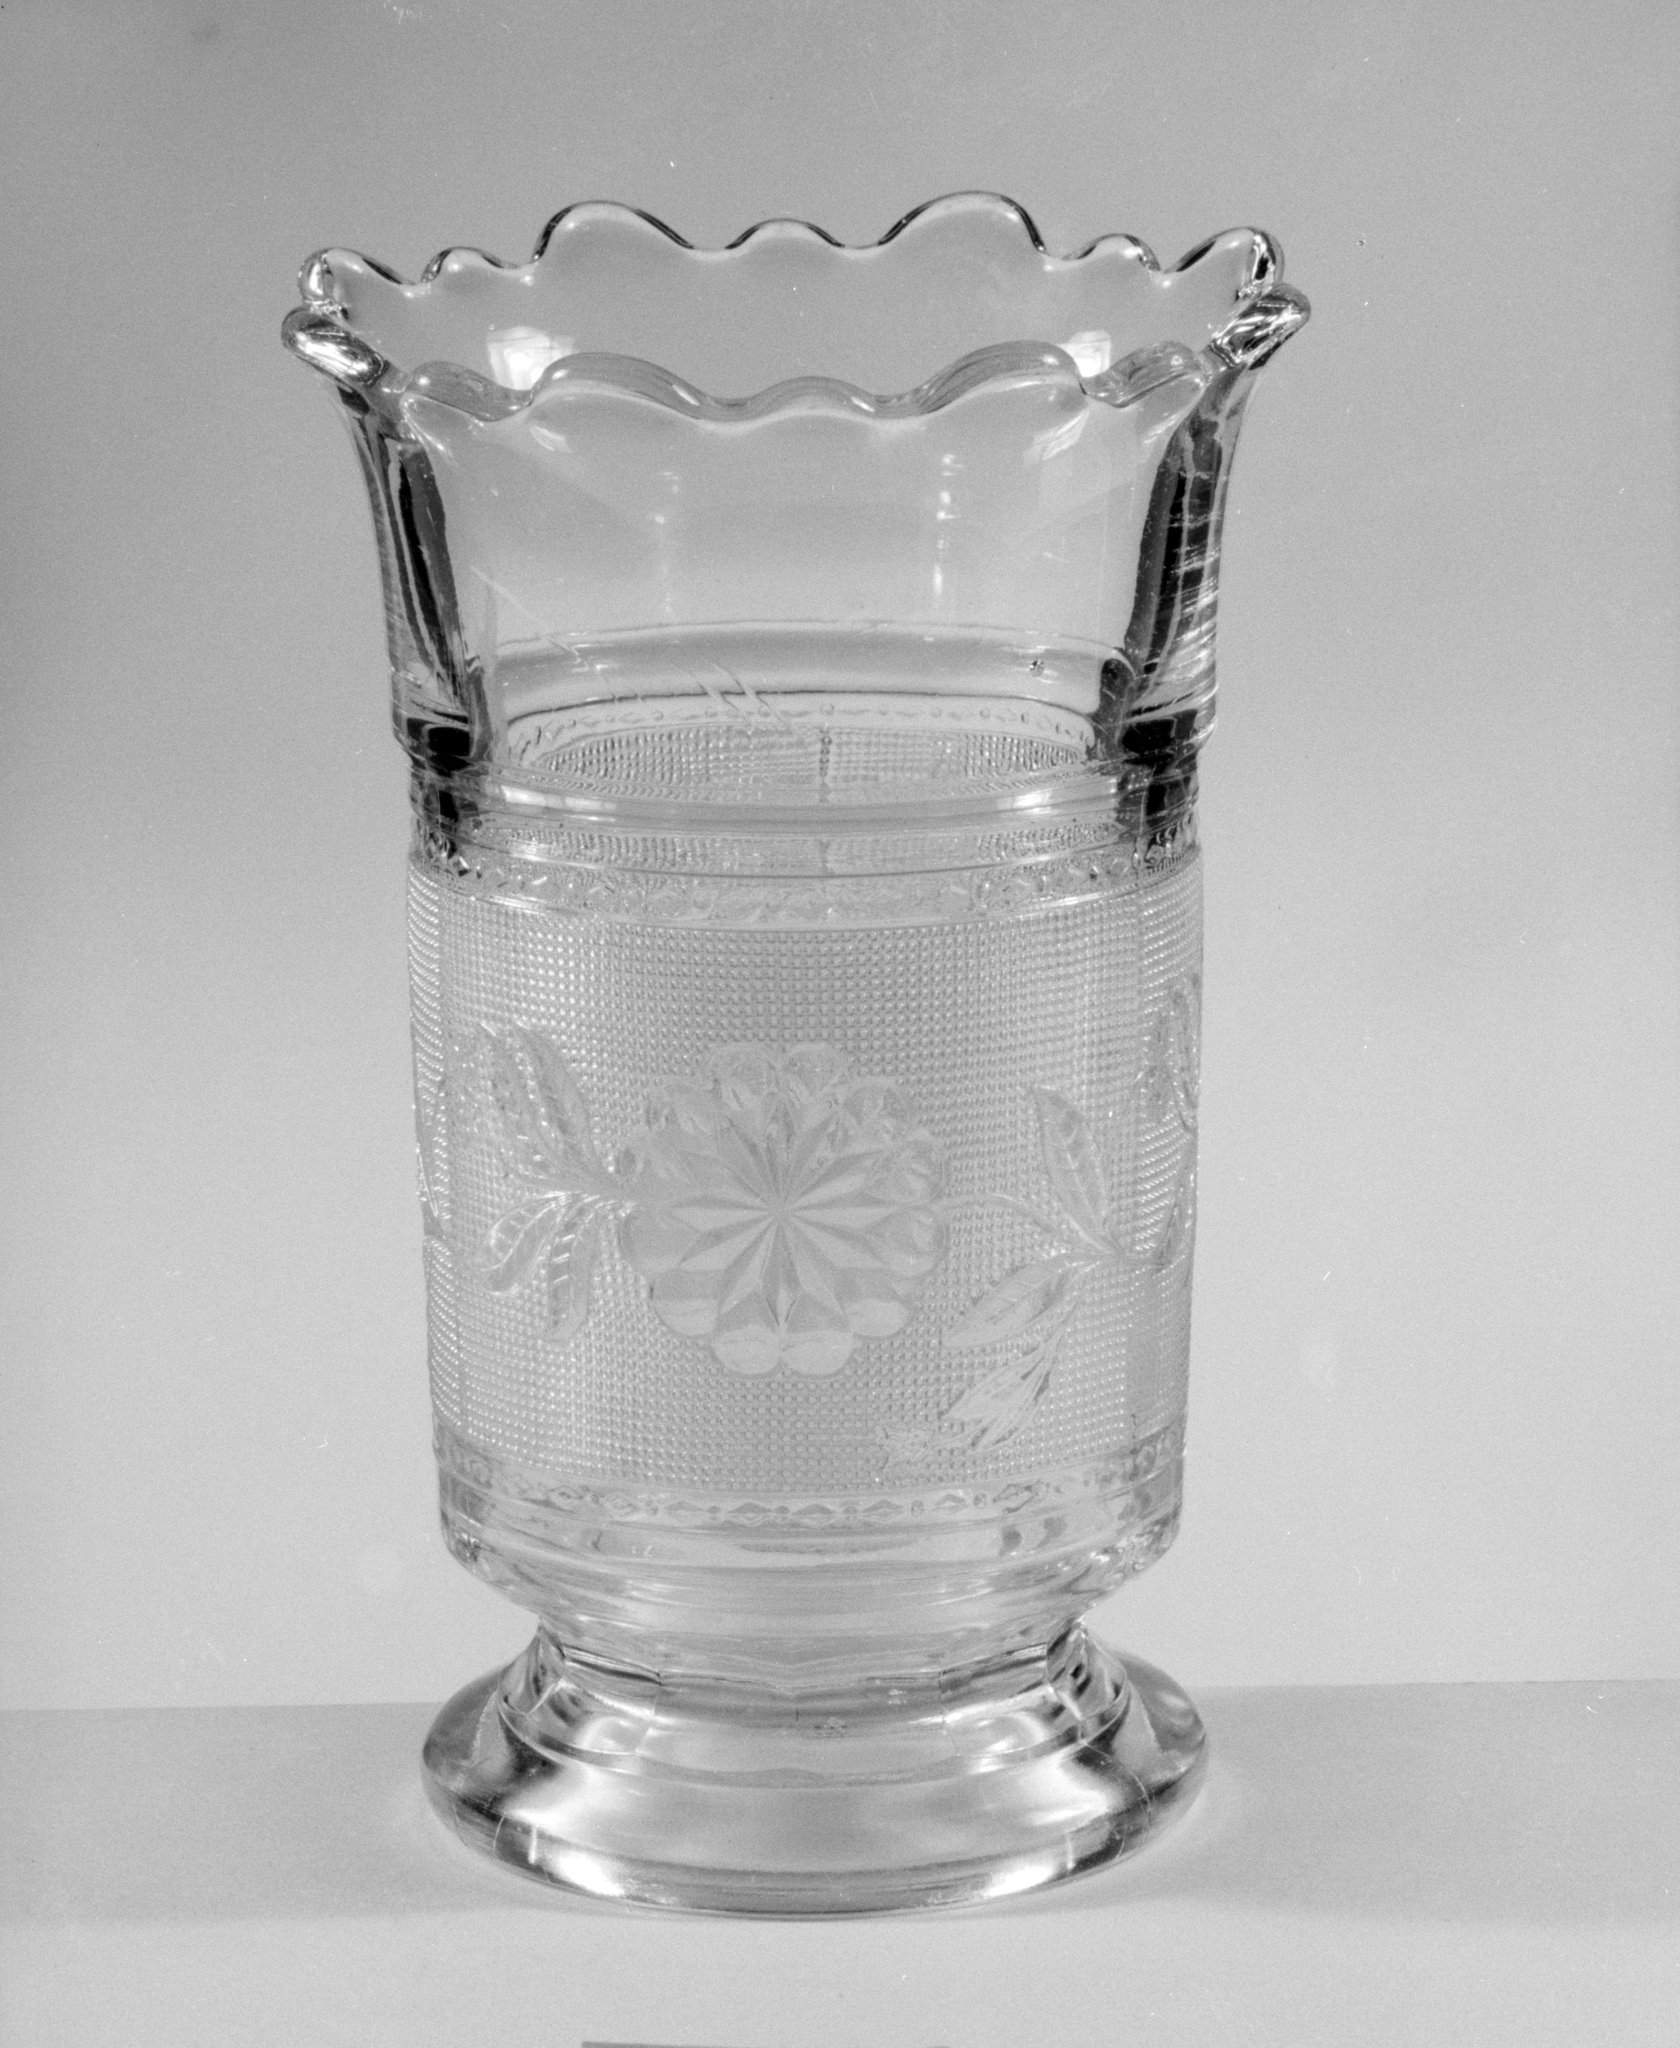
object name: celery vase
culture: american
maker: portland glass company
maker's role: maker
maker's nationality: american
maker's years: 1864-1873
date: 1865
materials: glass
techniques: pressed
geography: united states